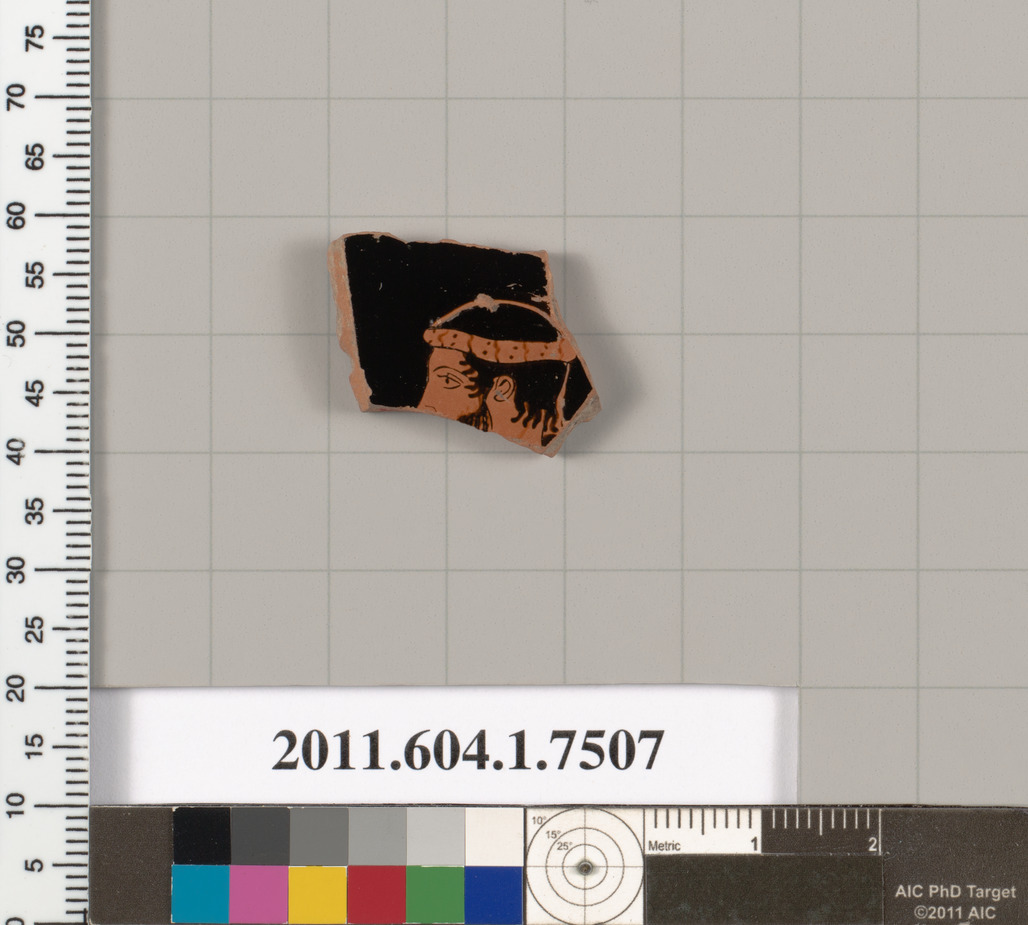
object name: kylix fragment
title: Terracotta fragment of a kylix (drinking cup)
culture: greek, attic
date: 460-450 BCE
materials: terracotta